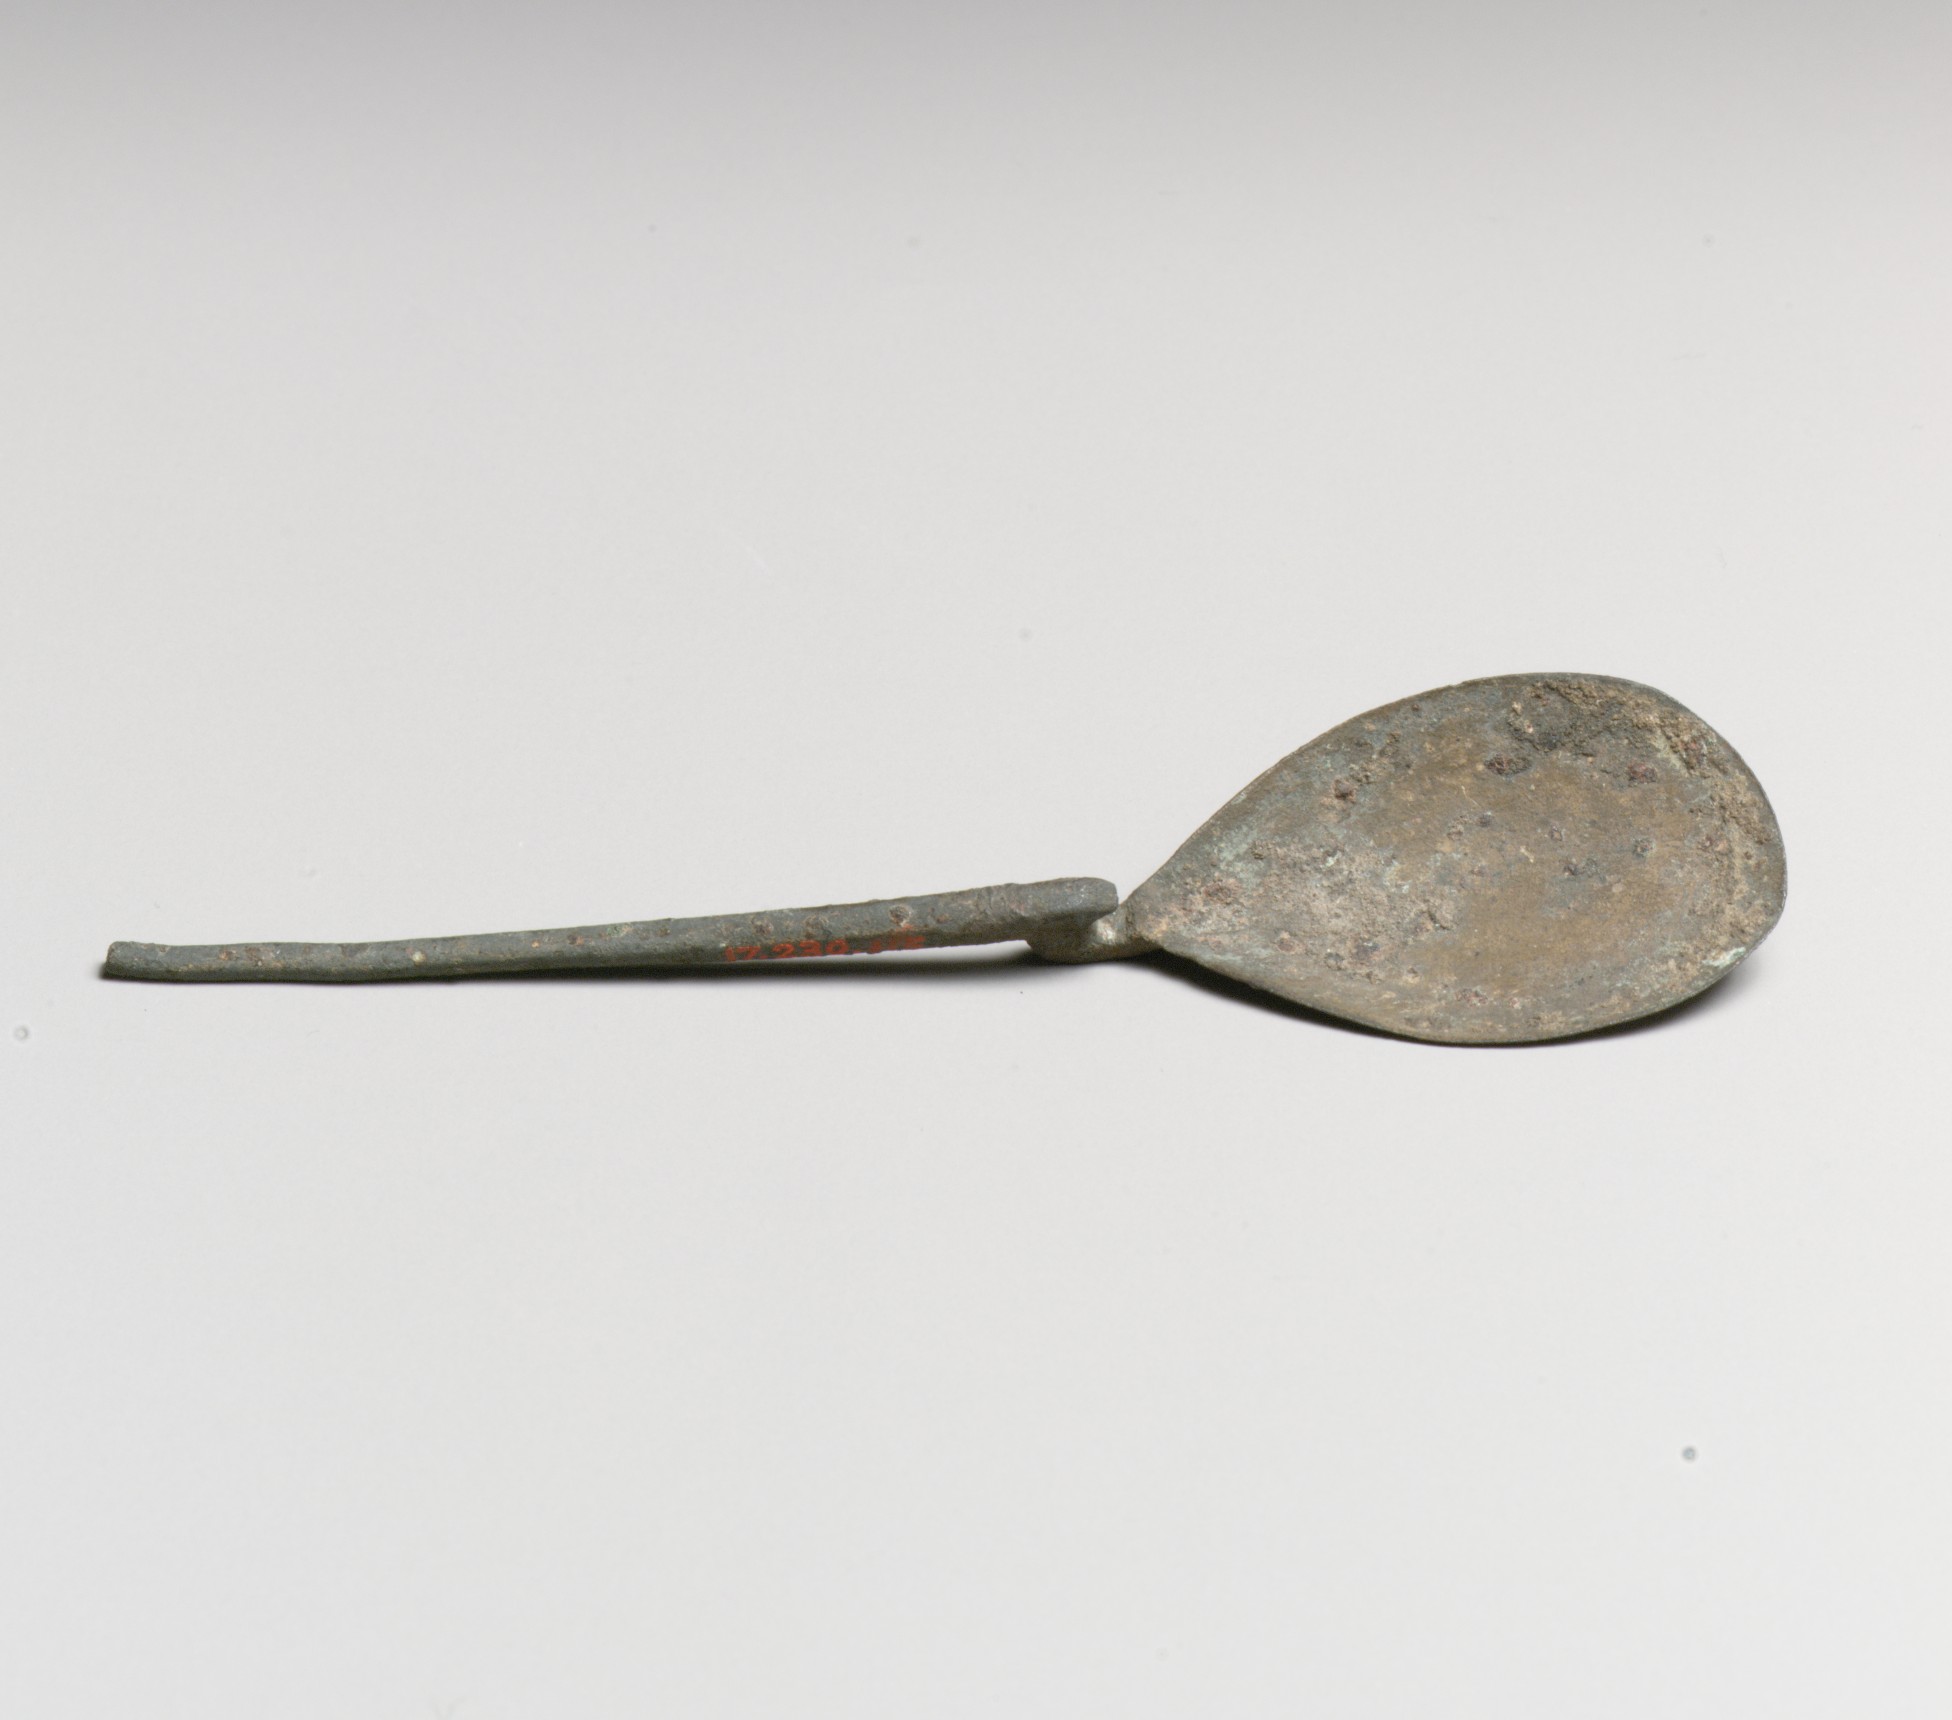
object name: spoon probe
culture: roman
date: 670 BCE-330 CE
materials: bronze, silver